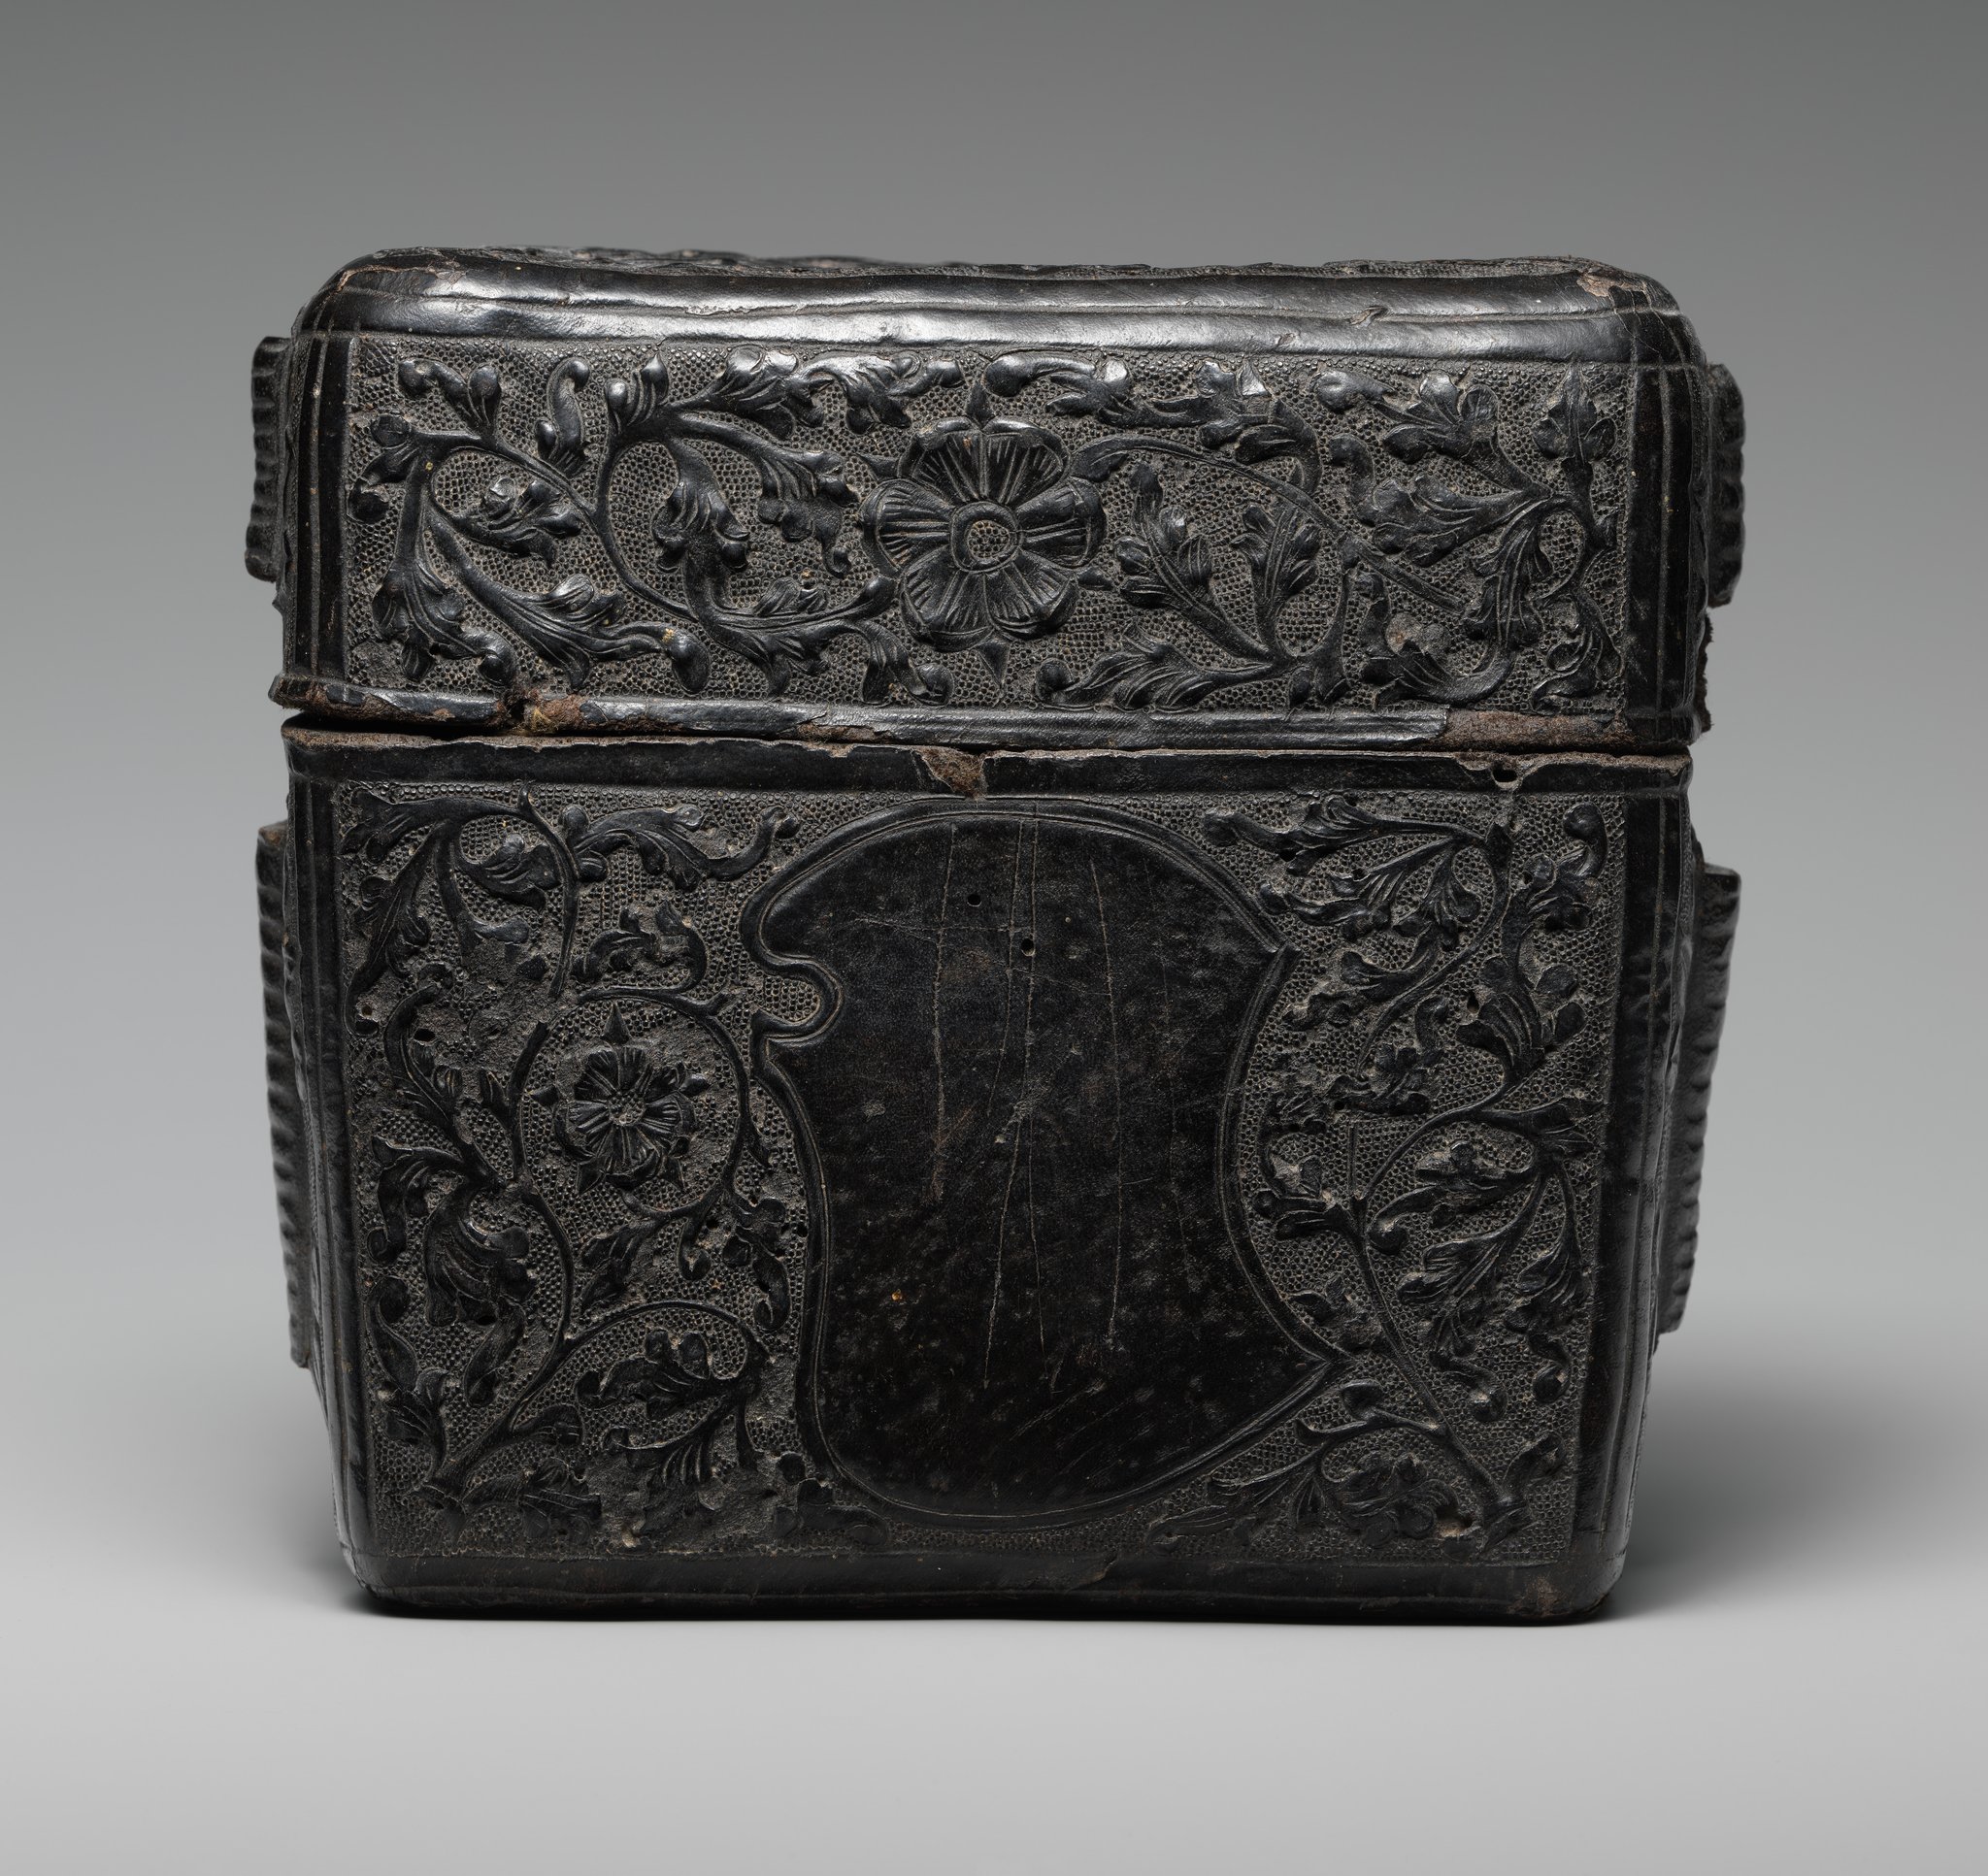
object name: book case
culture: italian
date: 1401-1500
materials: leather